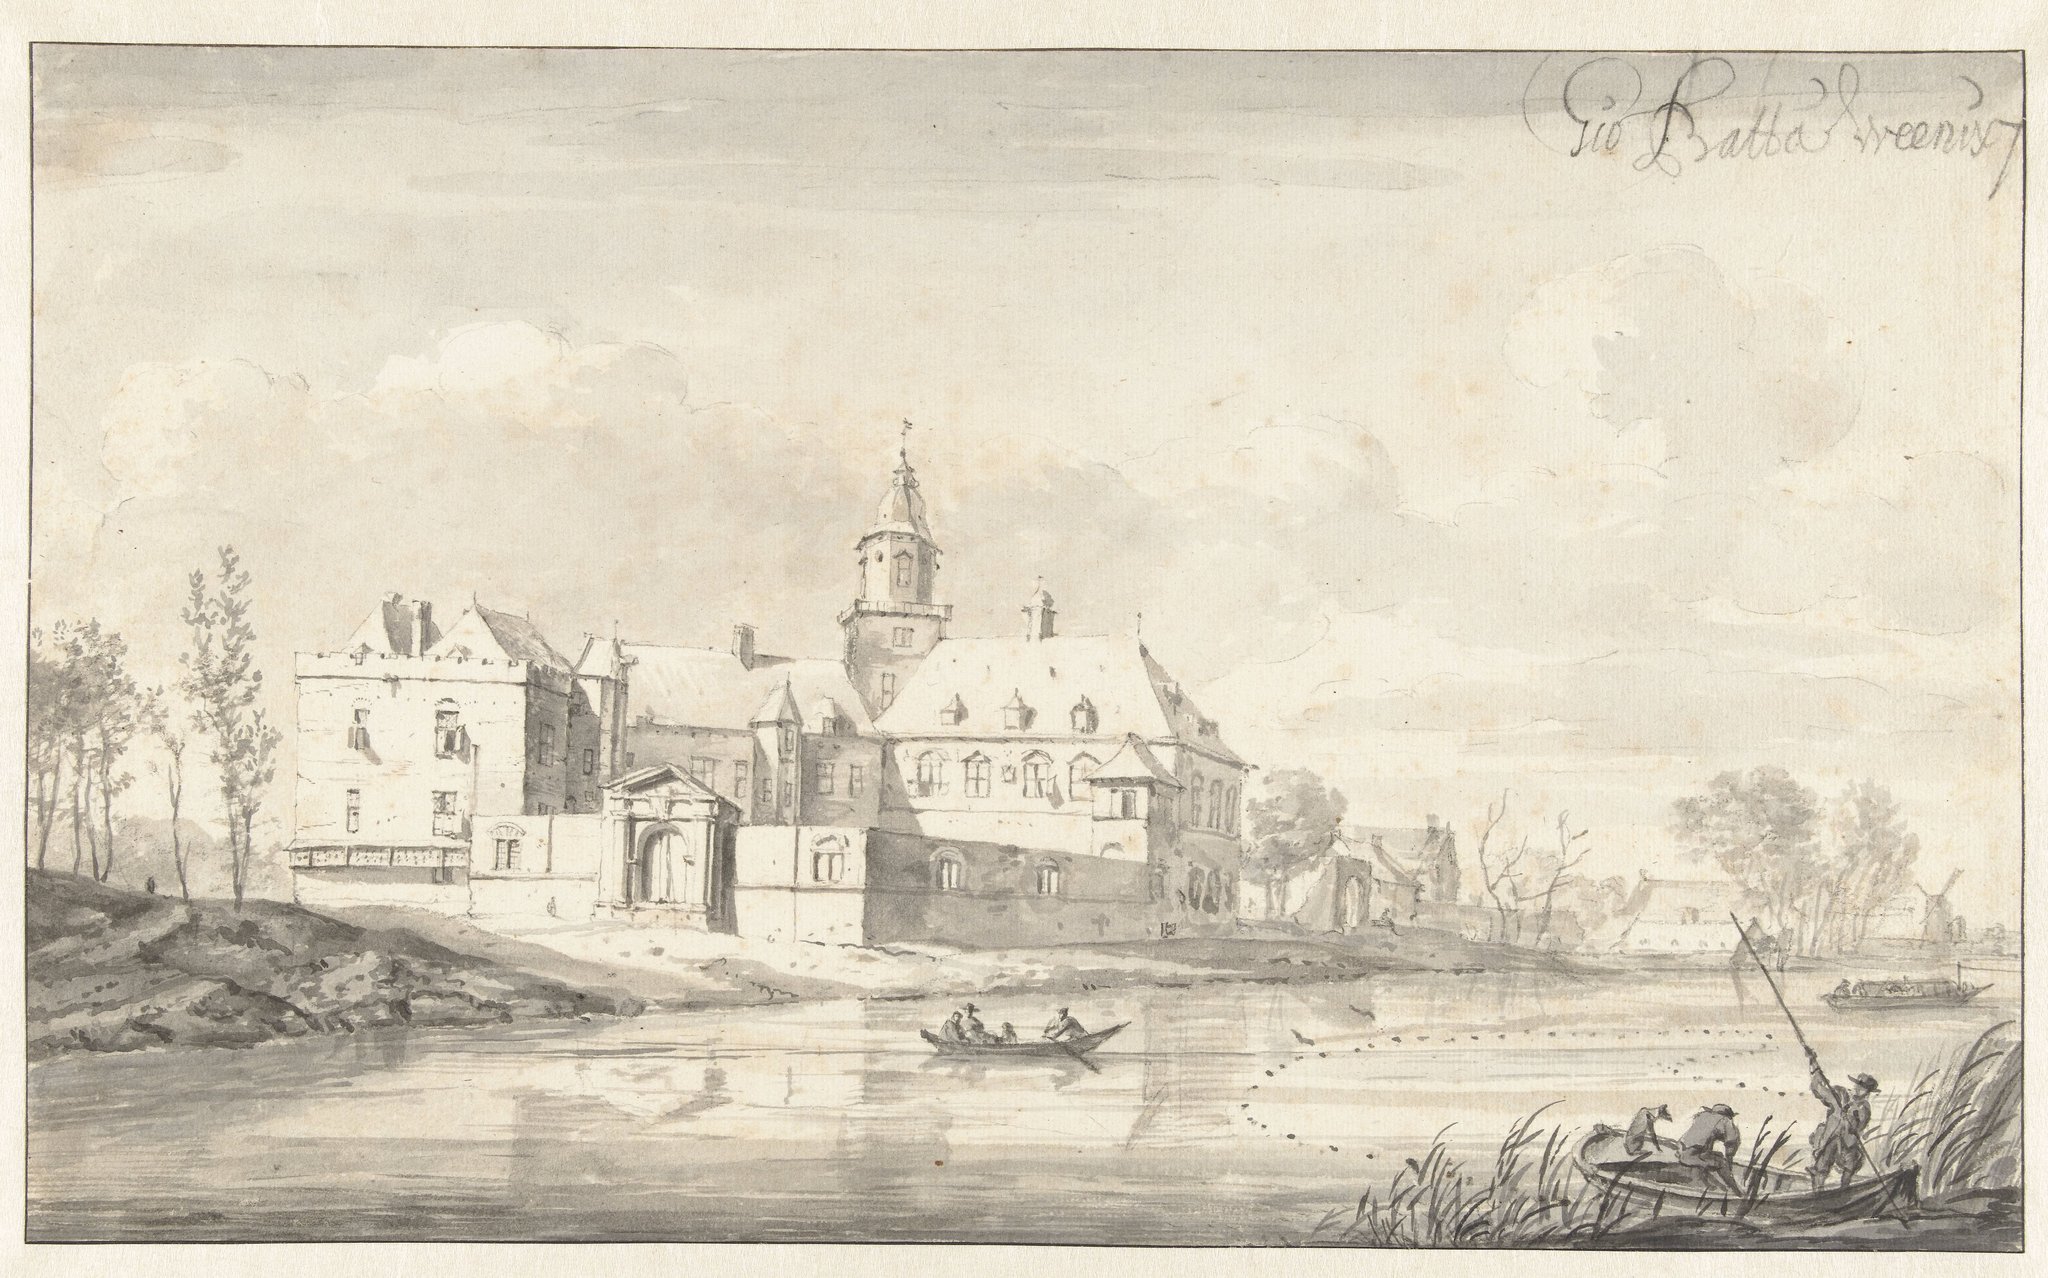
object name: drawing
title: View of Nijenrode Castle on the River Vecht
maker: jan baptist weenix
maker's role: draughtsman, painter, print maker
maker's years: 1621-1661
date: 1647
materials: chalk, paper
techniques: brush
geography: kasteel nijenrode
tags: castle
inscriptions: inscription: ‘N 3608’, inscription: ‘No 116 (?) [...] I N (?)’, signature: ‘Gio Batta Weenix7’, inscription: ‘Nyenrode / J.B. Weenix’